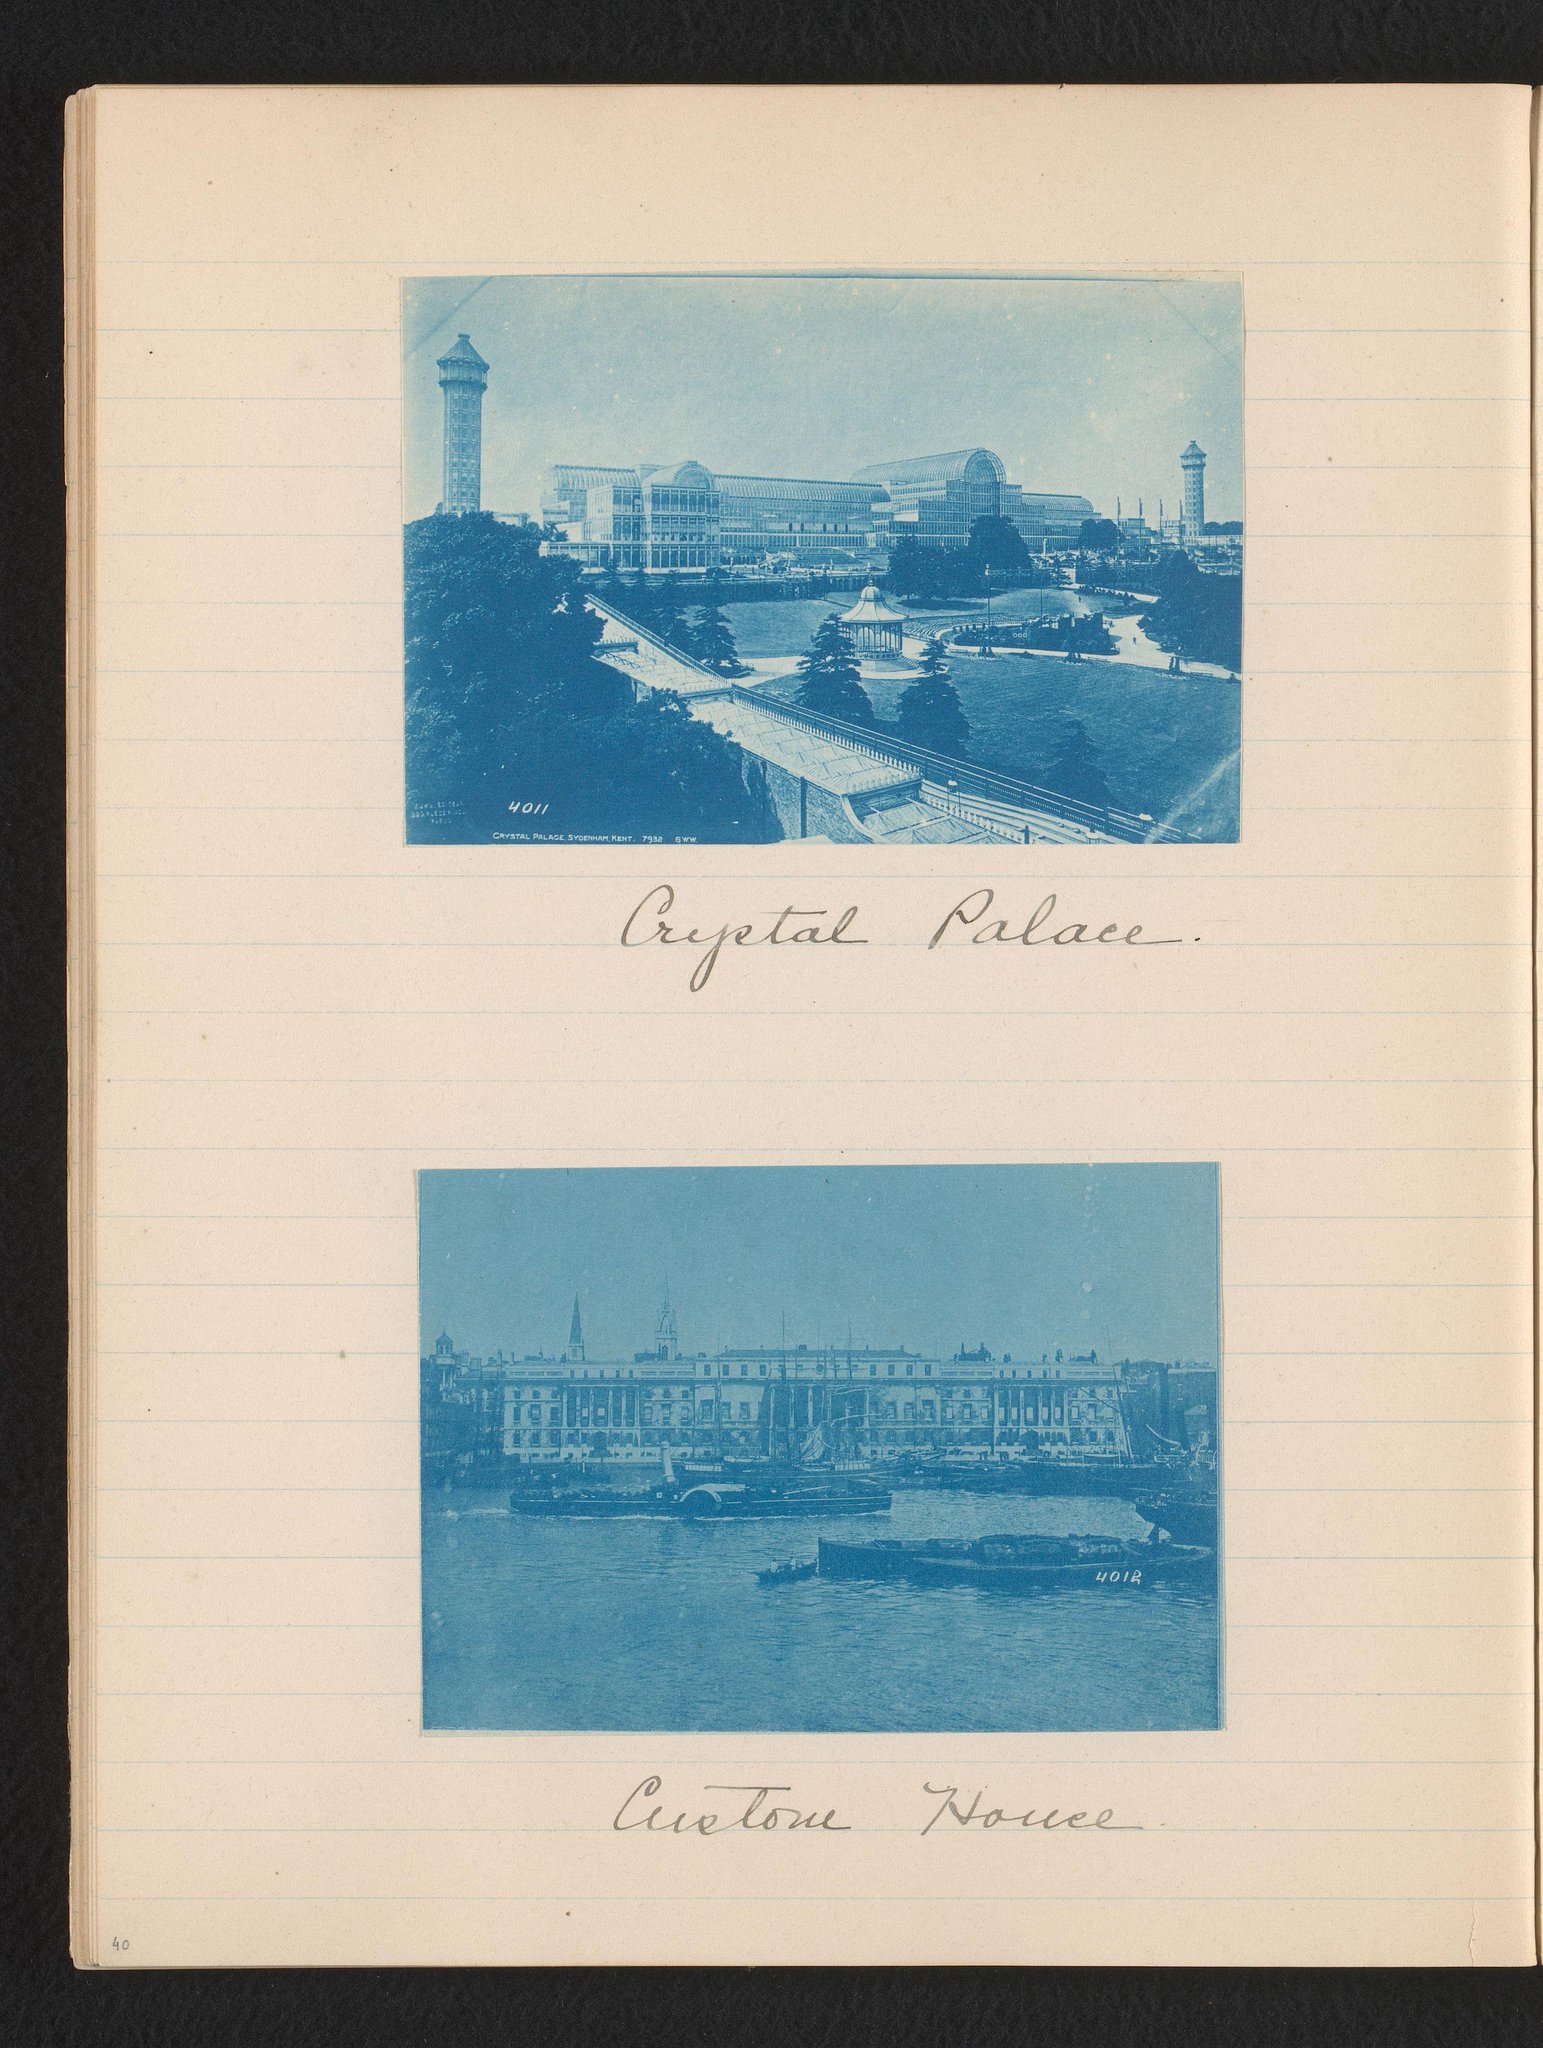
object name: photograph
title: Twee foto's van Crystal Palace en Custom House, Londen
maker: Anonymous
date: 1901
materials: paper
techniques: cyanotype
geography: london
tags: customs, world fair, world exhibition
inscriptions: inscription: ‘Crystal Palace./ Custom House.’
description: Deze foto's maken deel uit van een album.